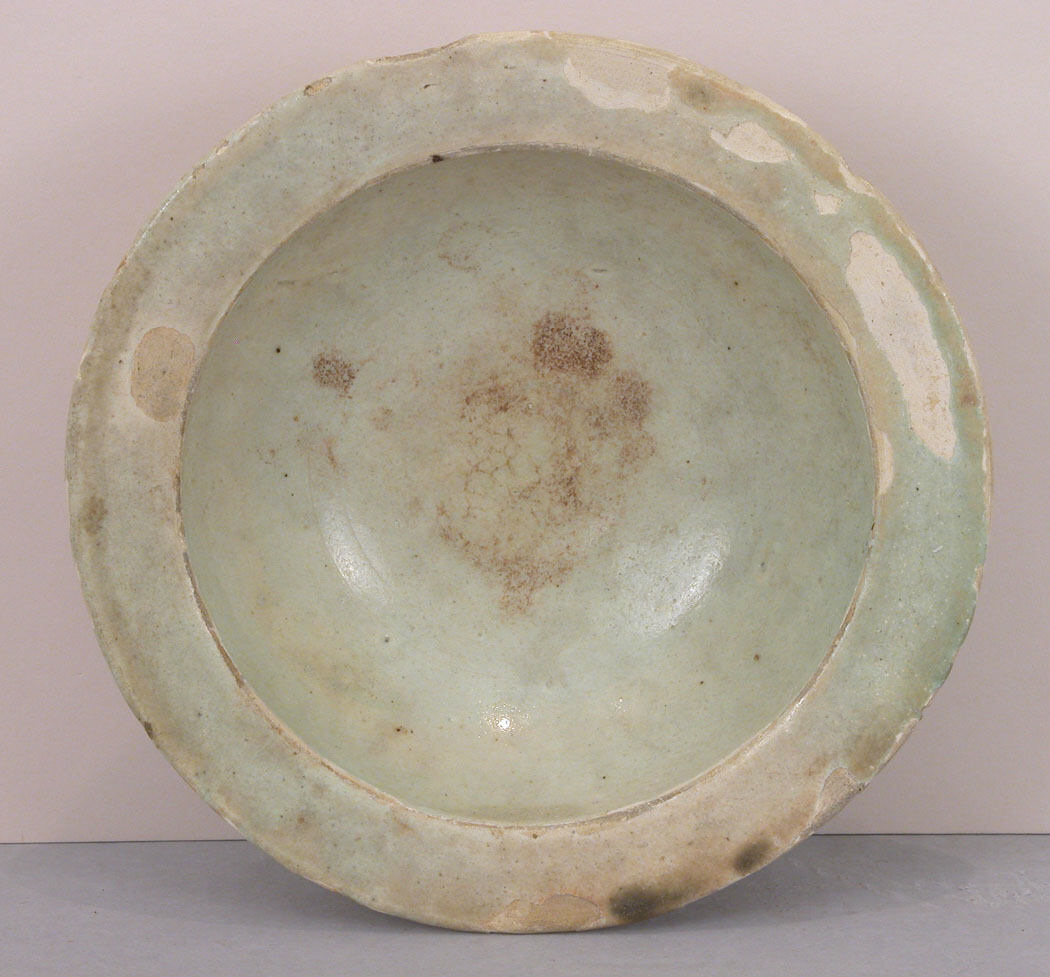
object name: bowl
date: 1301-1500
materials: glaze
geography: syria